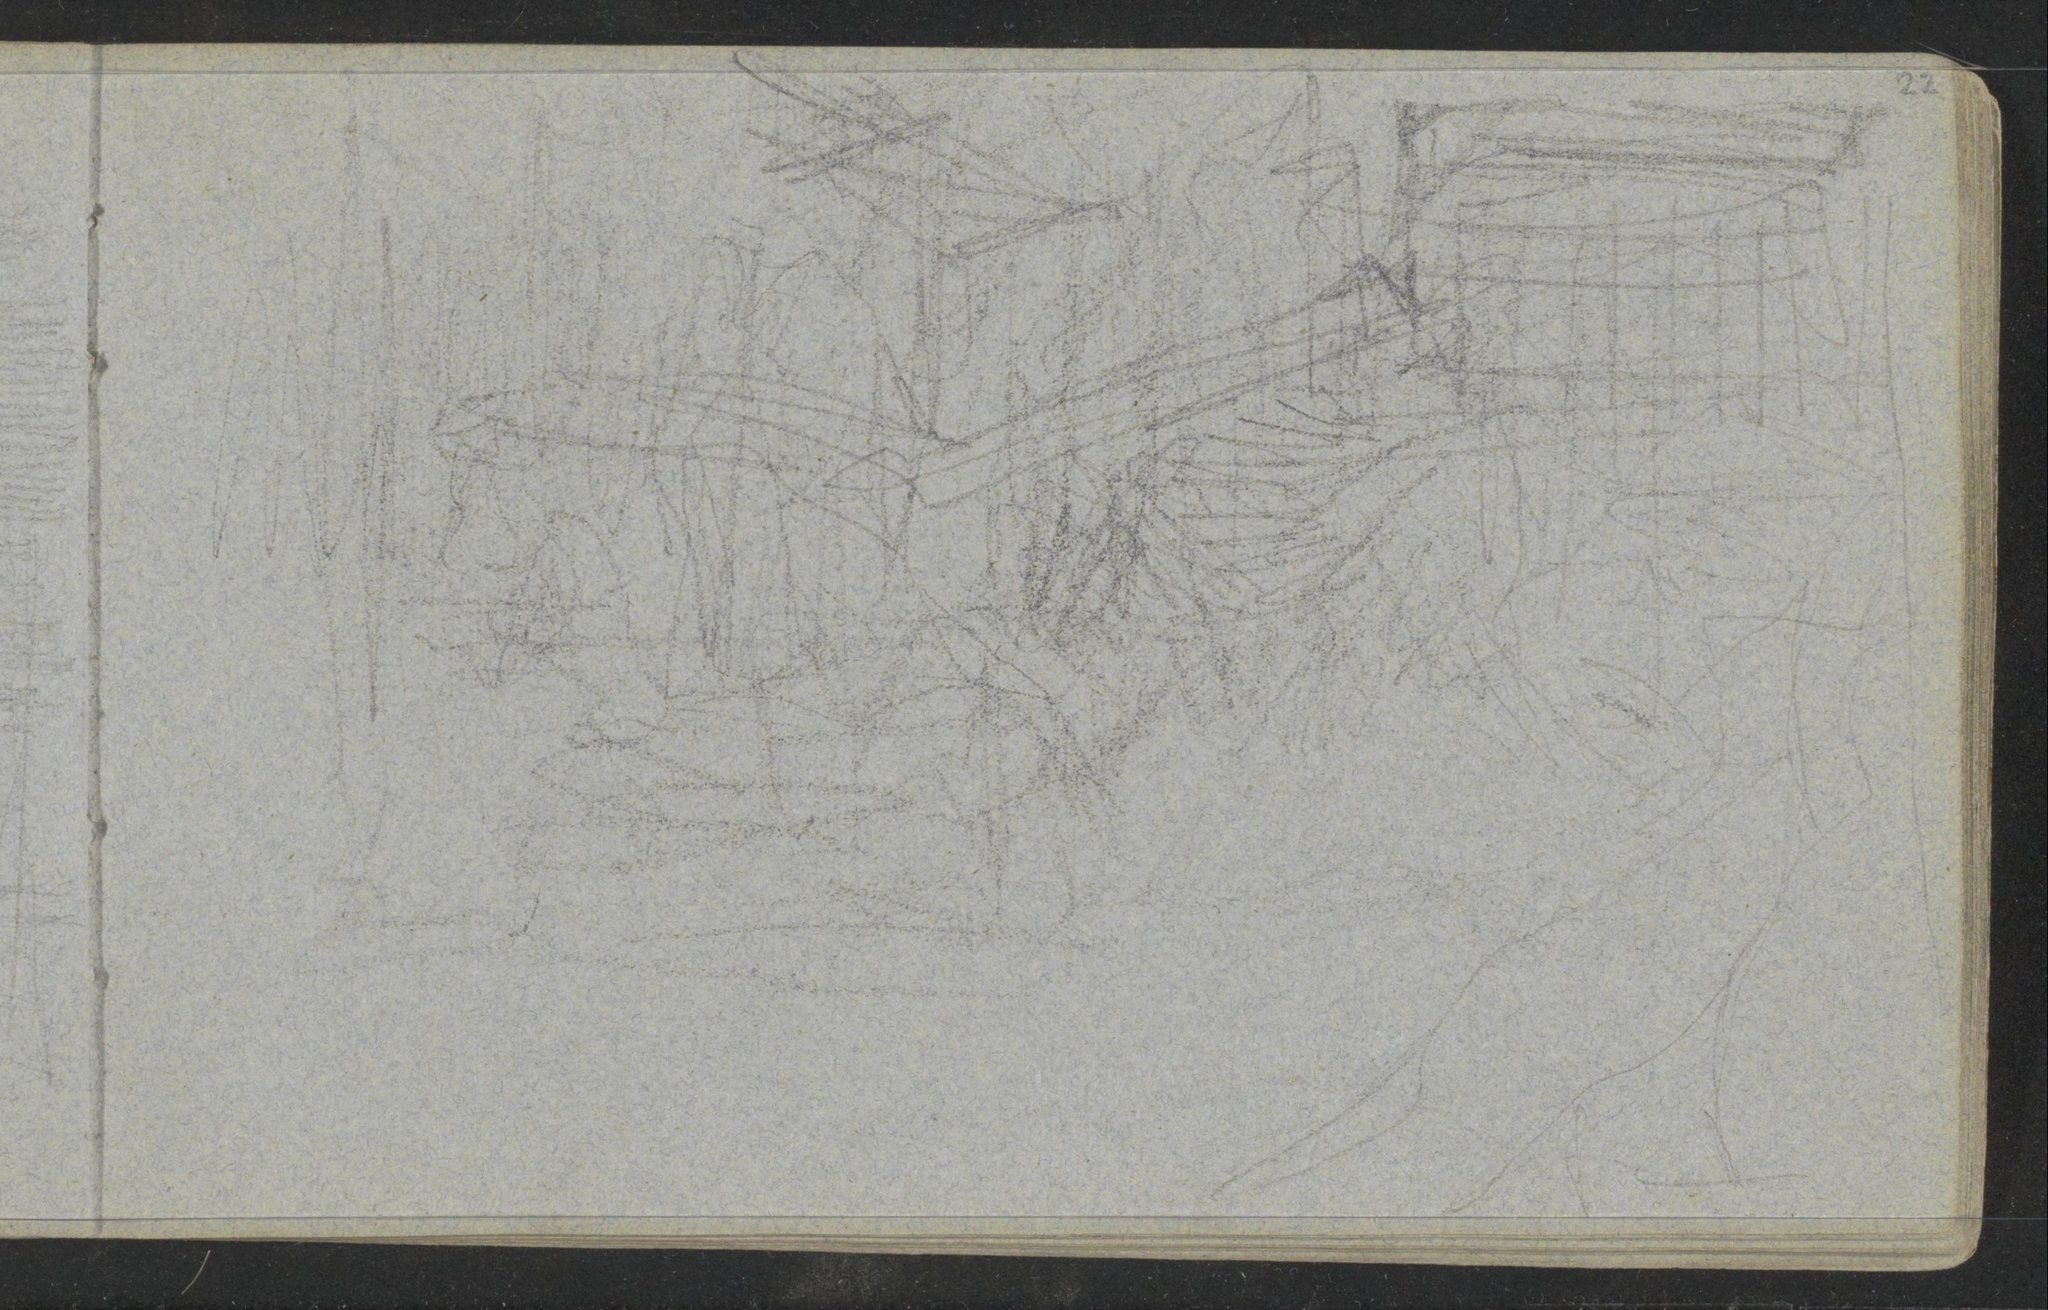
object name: sketchbook leaf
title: Studie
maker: matthijs maris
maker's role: draughtsman, painter, print maker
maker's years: 1839-1917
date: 1849-1917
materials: paper, pencil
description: Blad 22 recto uit een schetsboek met 35 bladen.